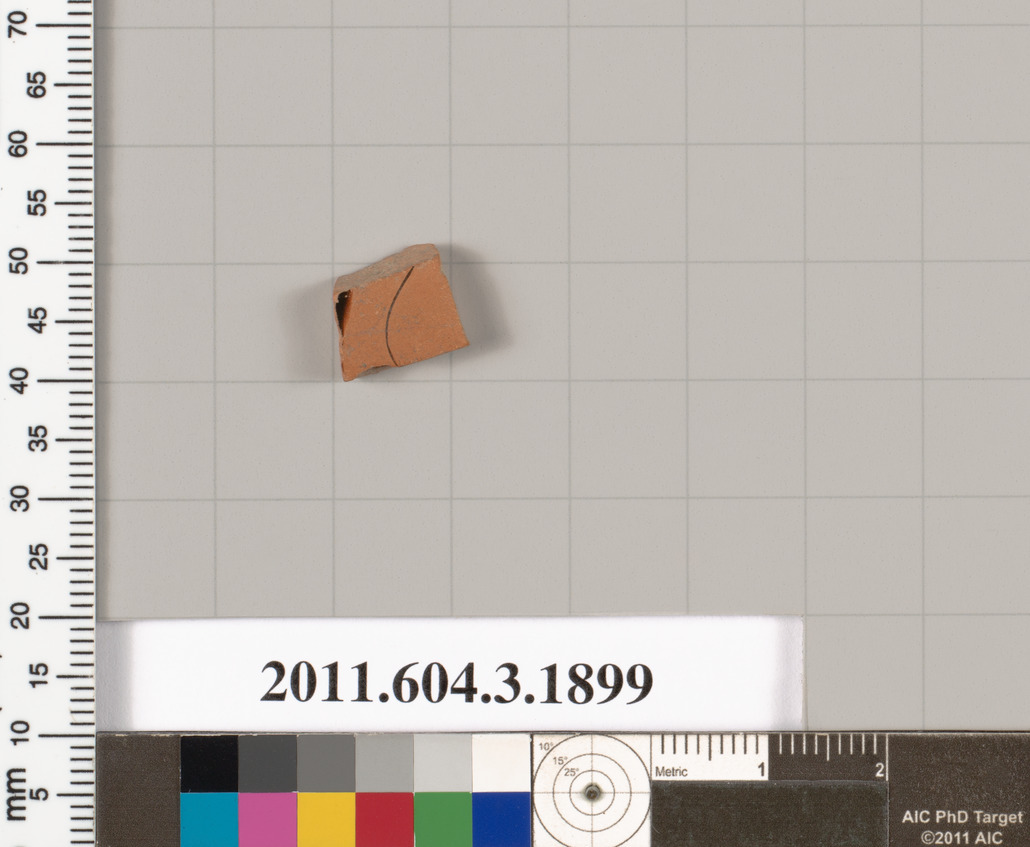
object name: undetermined open shape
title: Terracotta fragment of an open shape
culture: greek, attic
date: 550-501 BCE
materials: terracotta